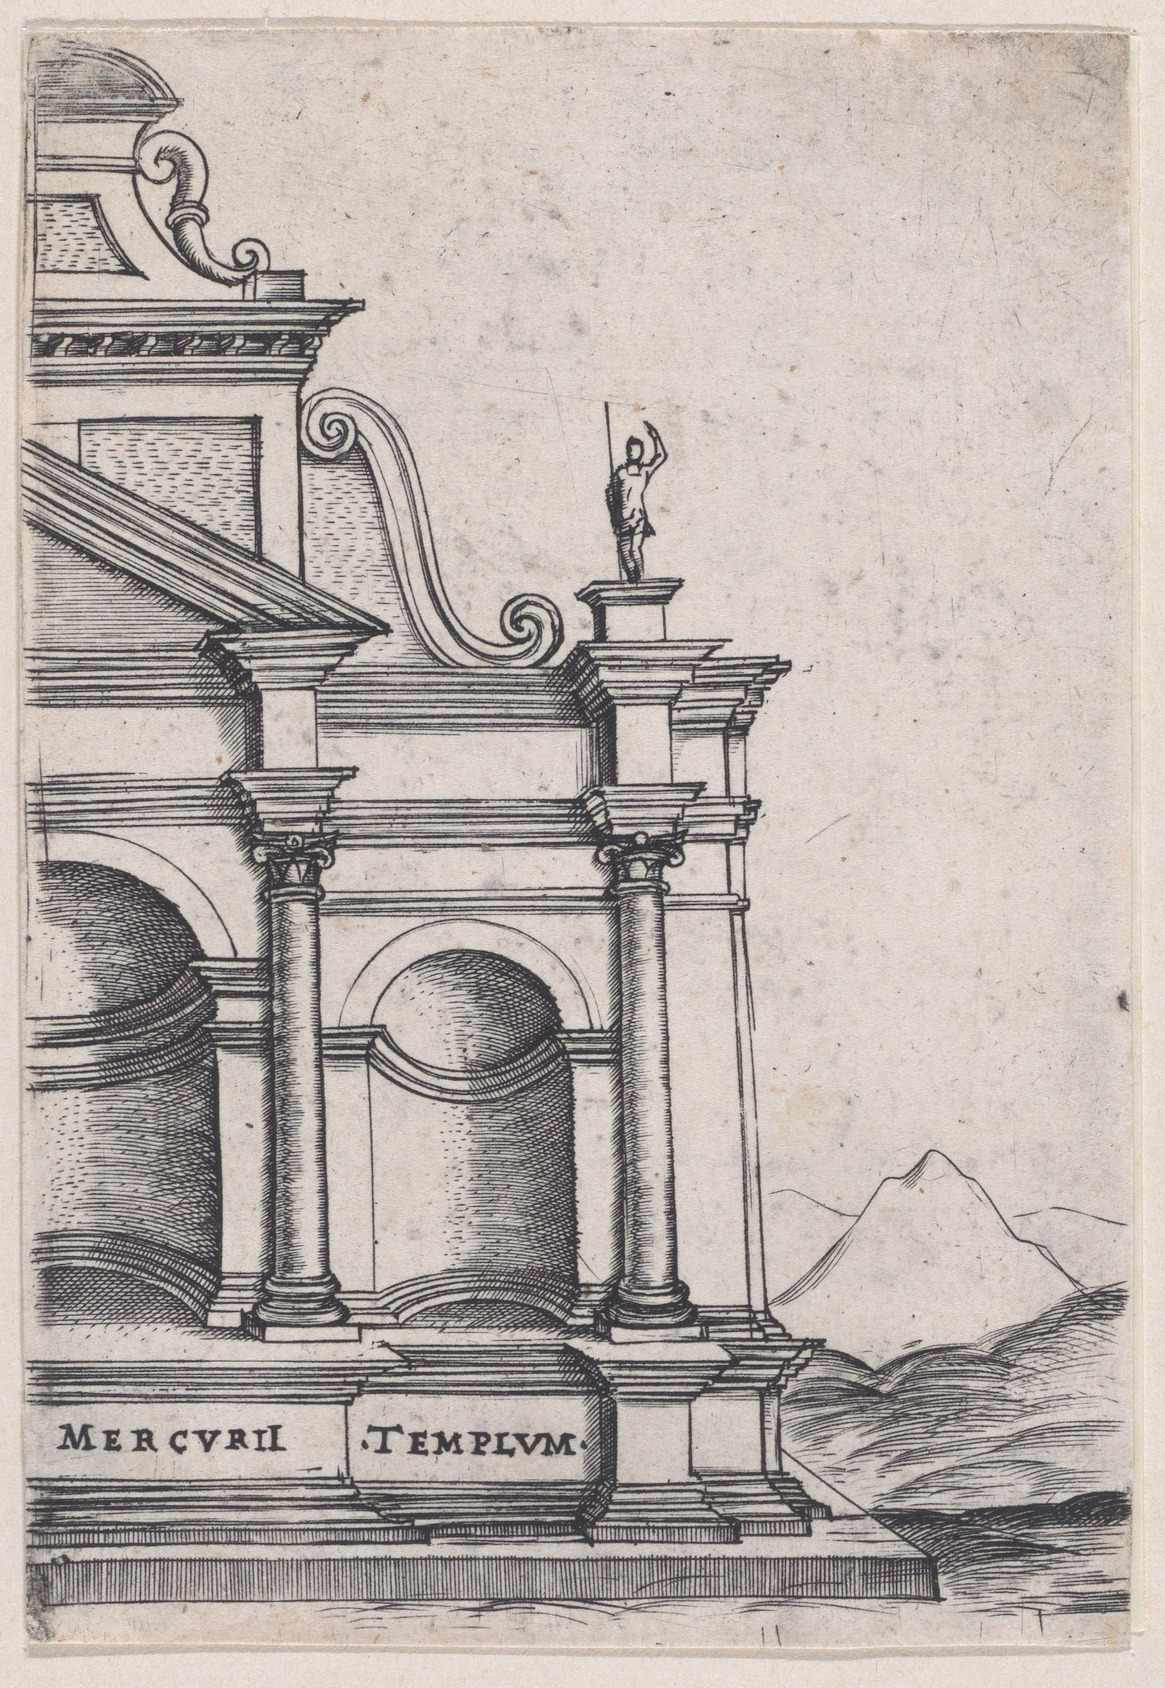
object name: print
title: Mercurii Templum, from "Views of Ancient Roman Temples and Arches"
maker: anonymous, italian, 16th century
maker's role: artist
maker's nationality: italian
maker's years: 1500-1600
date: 1535-1540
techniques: engraving